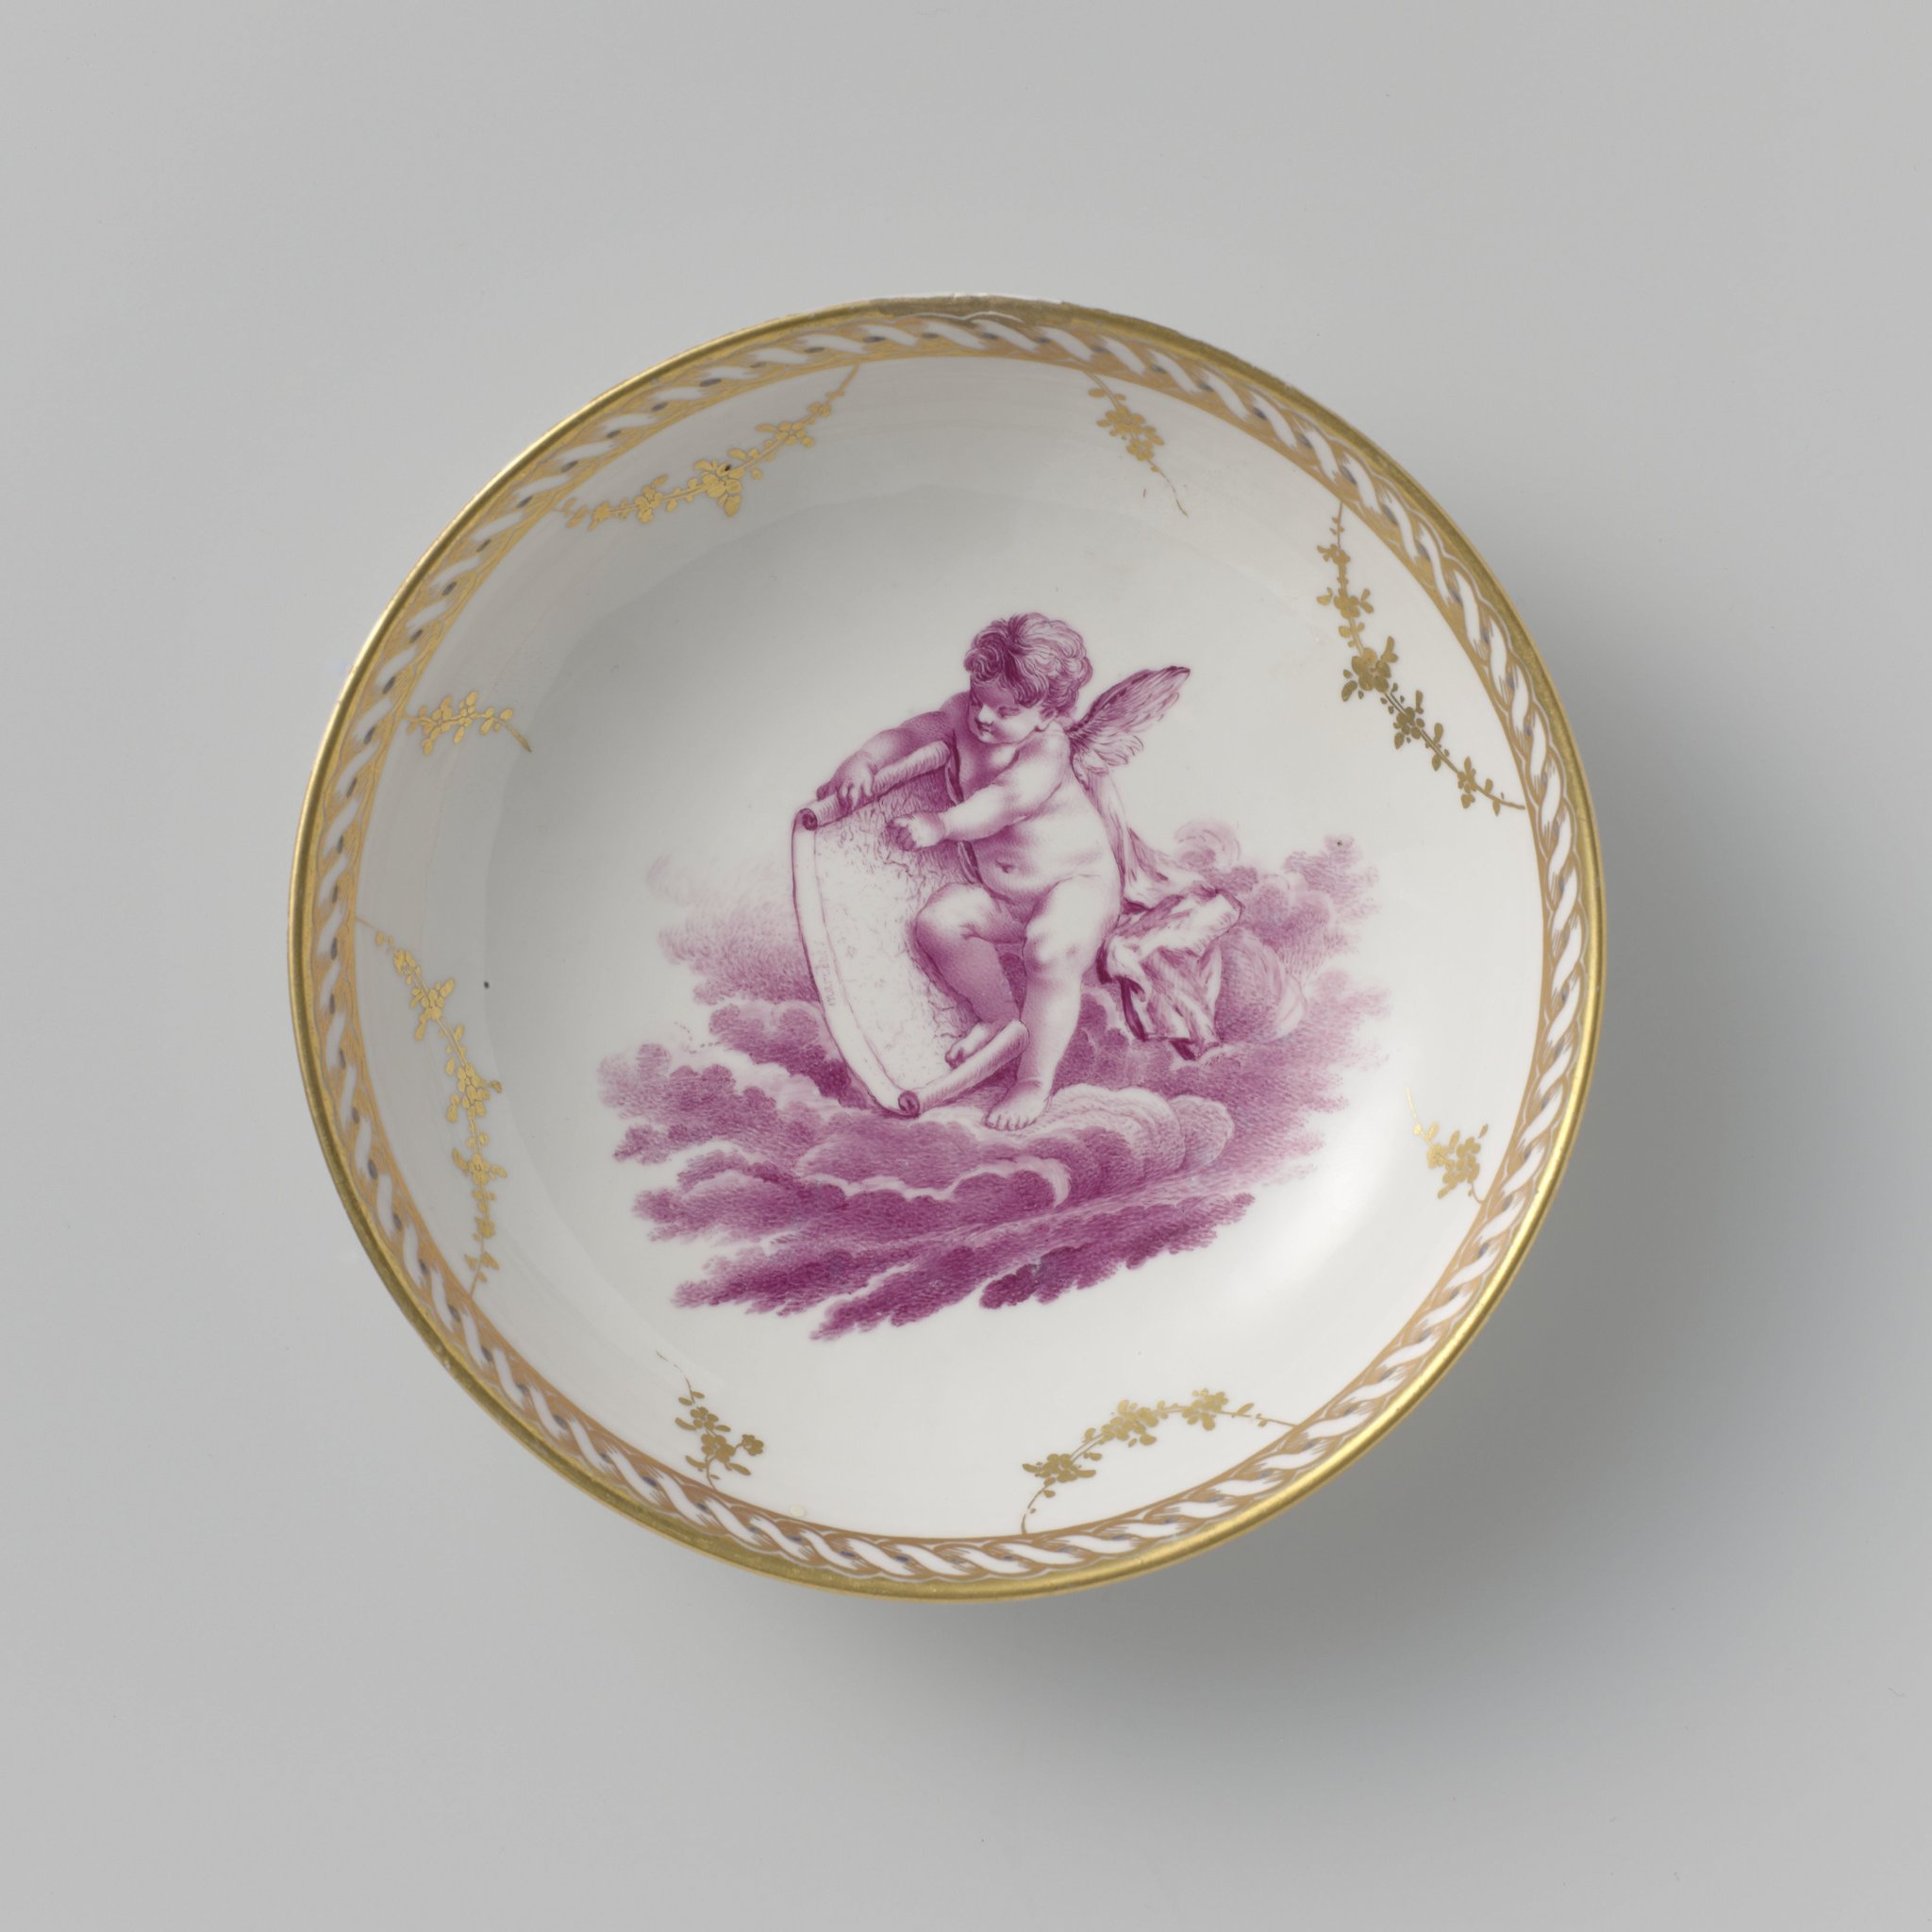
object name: platter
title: Saucer with a putto on clouds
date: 1785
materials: glaze, gold, paint, porcelain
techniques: firing, forming, gilding, turning, vitrification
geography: germany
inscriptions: inscription: ‘MARCKIES?’, mark: ‘ooievaar’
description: Schotel van porselein, beschilderd op het glazuur in roze (camaïeu) en goud. Op het plat een putto met een wereldkaart op een wolk. Op de kaart het opschrift 'MARCKIES'[?]. De binnenrand met een gedraaide band, waaraan guirlandes en bloemtakken hangen. Gouden rand. Gemerkt op de onderzijde met de ooievaar.